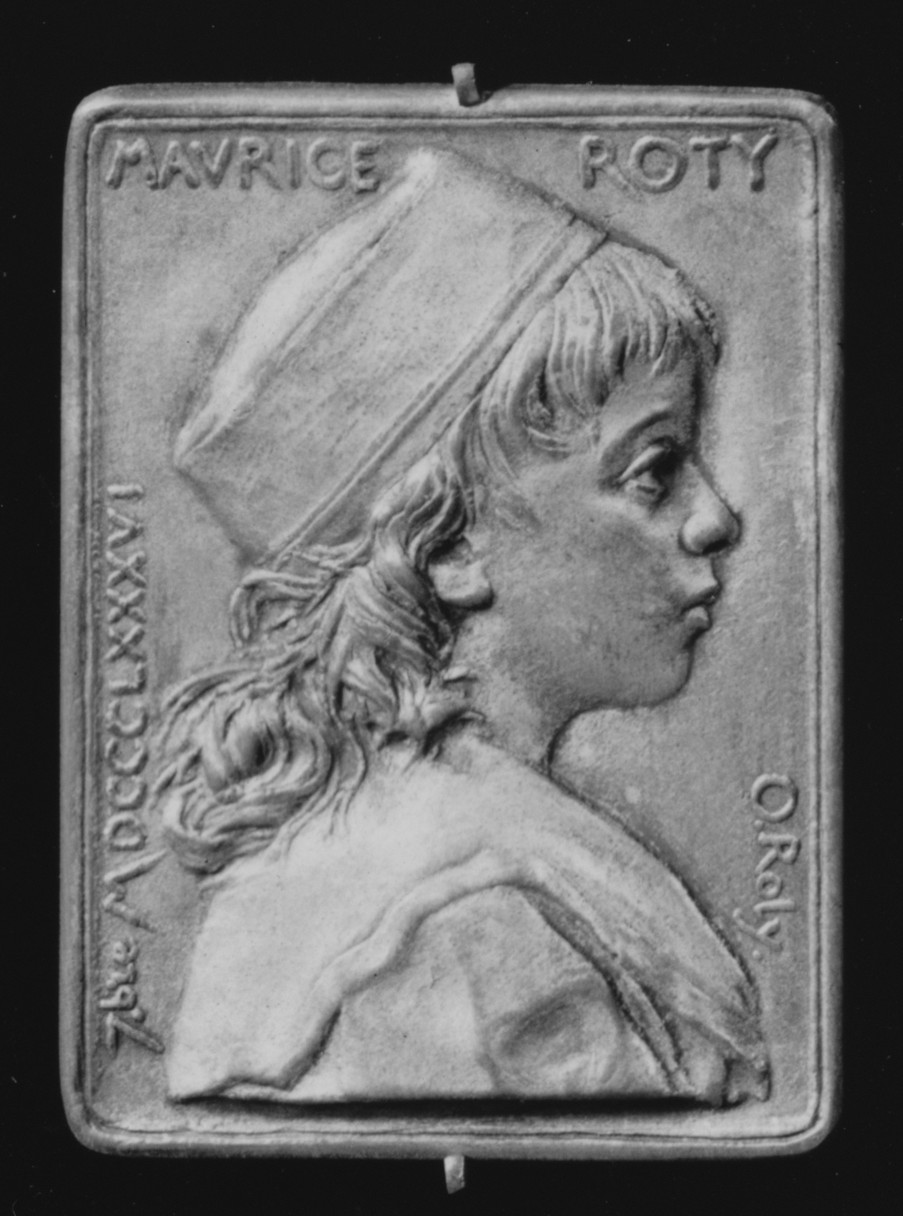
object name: plaquette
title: Maurice Roty, aet. 4 years, 4 months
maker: louis-oscar roty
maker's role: artist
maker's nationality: french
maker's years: 1846-1911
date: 1886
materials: bronze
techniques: casting, silvered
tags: profiles,women